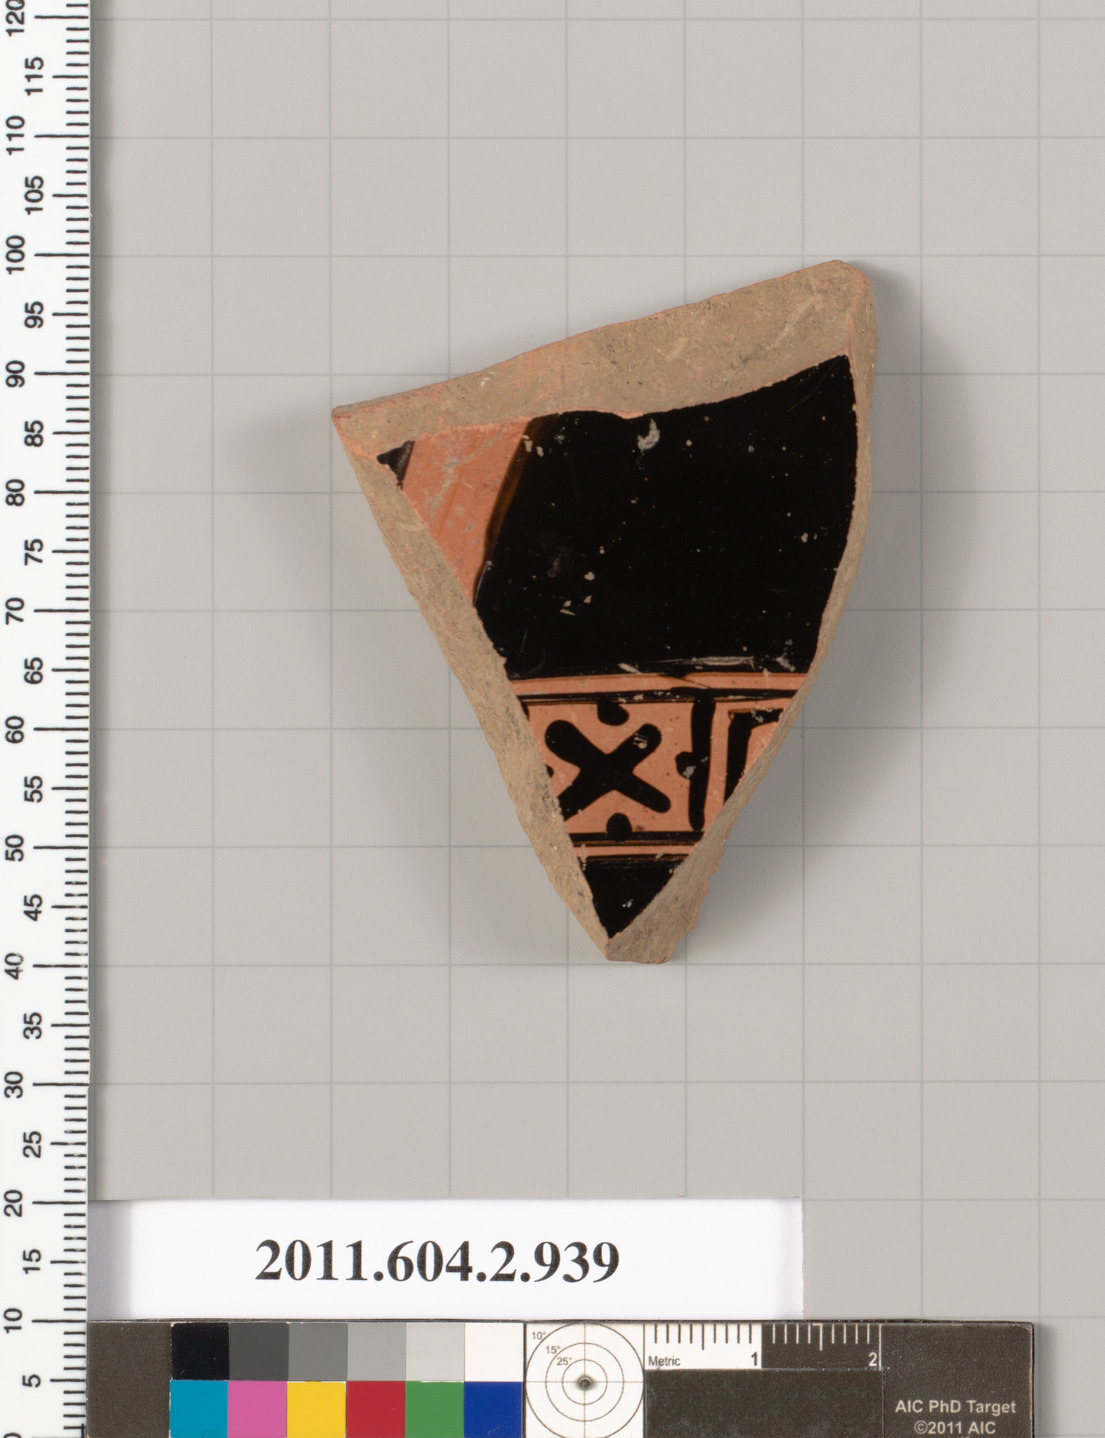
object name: bell krater fragment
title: Terracotta fragment of a bell-krater (bowl for mixing wine and water)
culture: greek, attic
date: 440-430 BCE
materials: terracotta